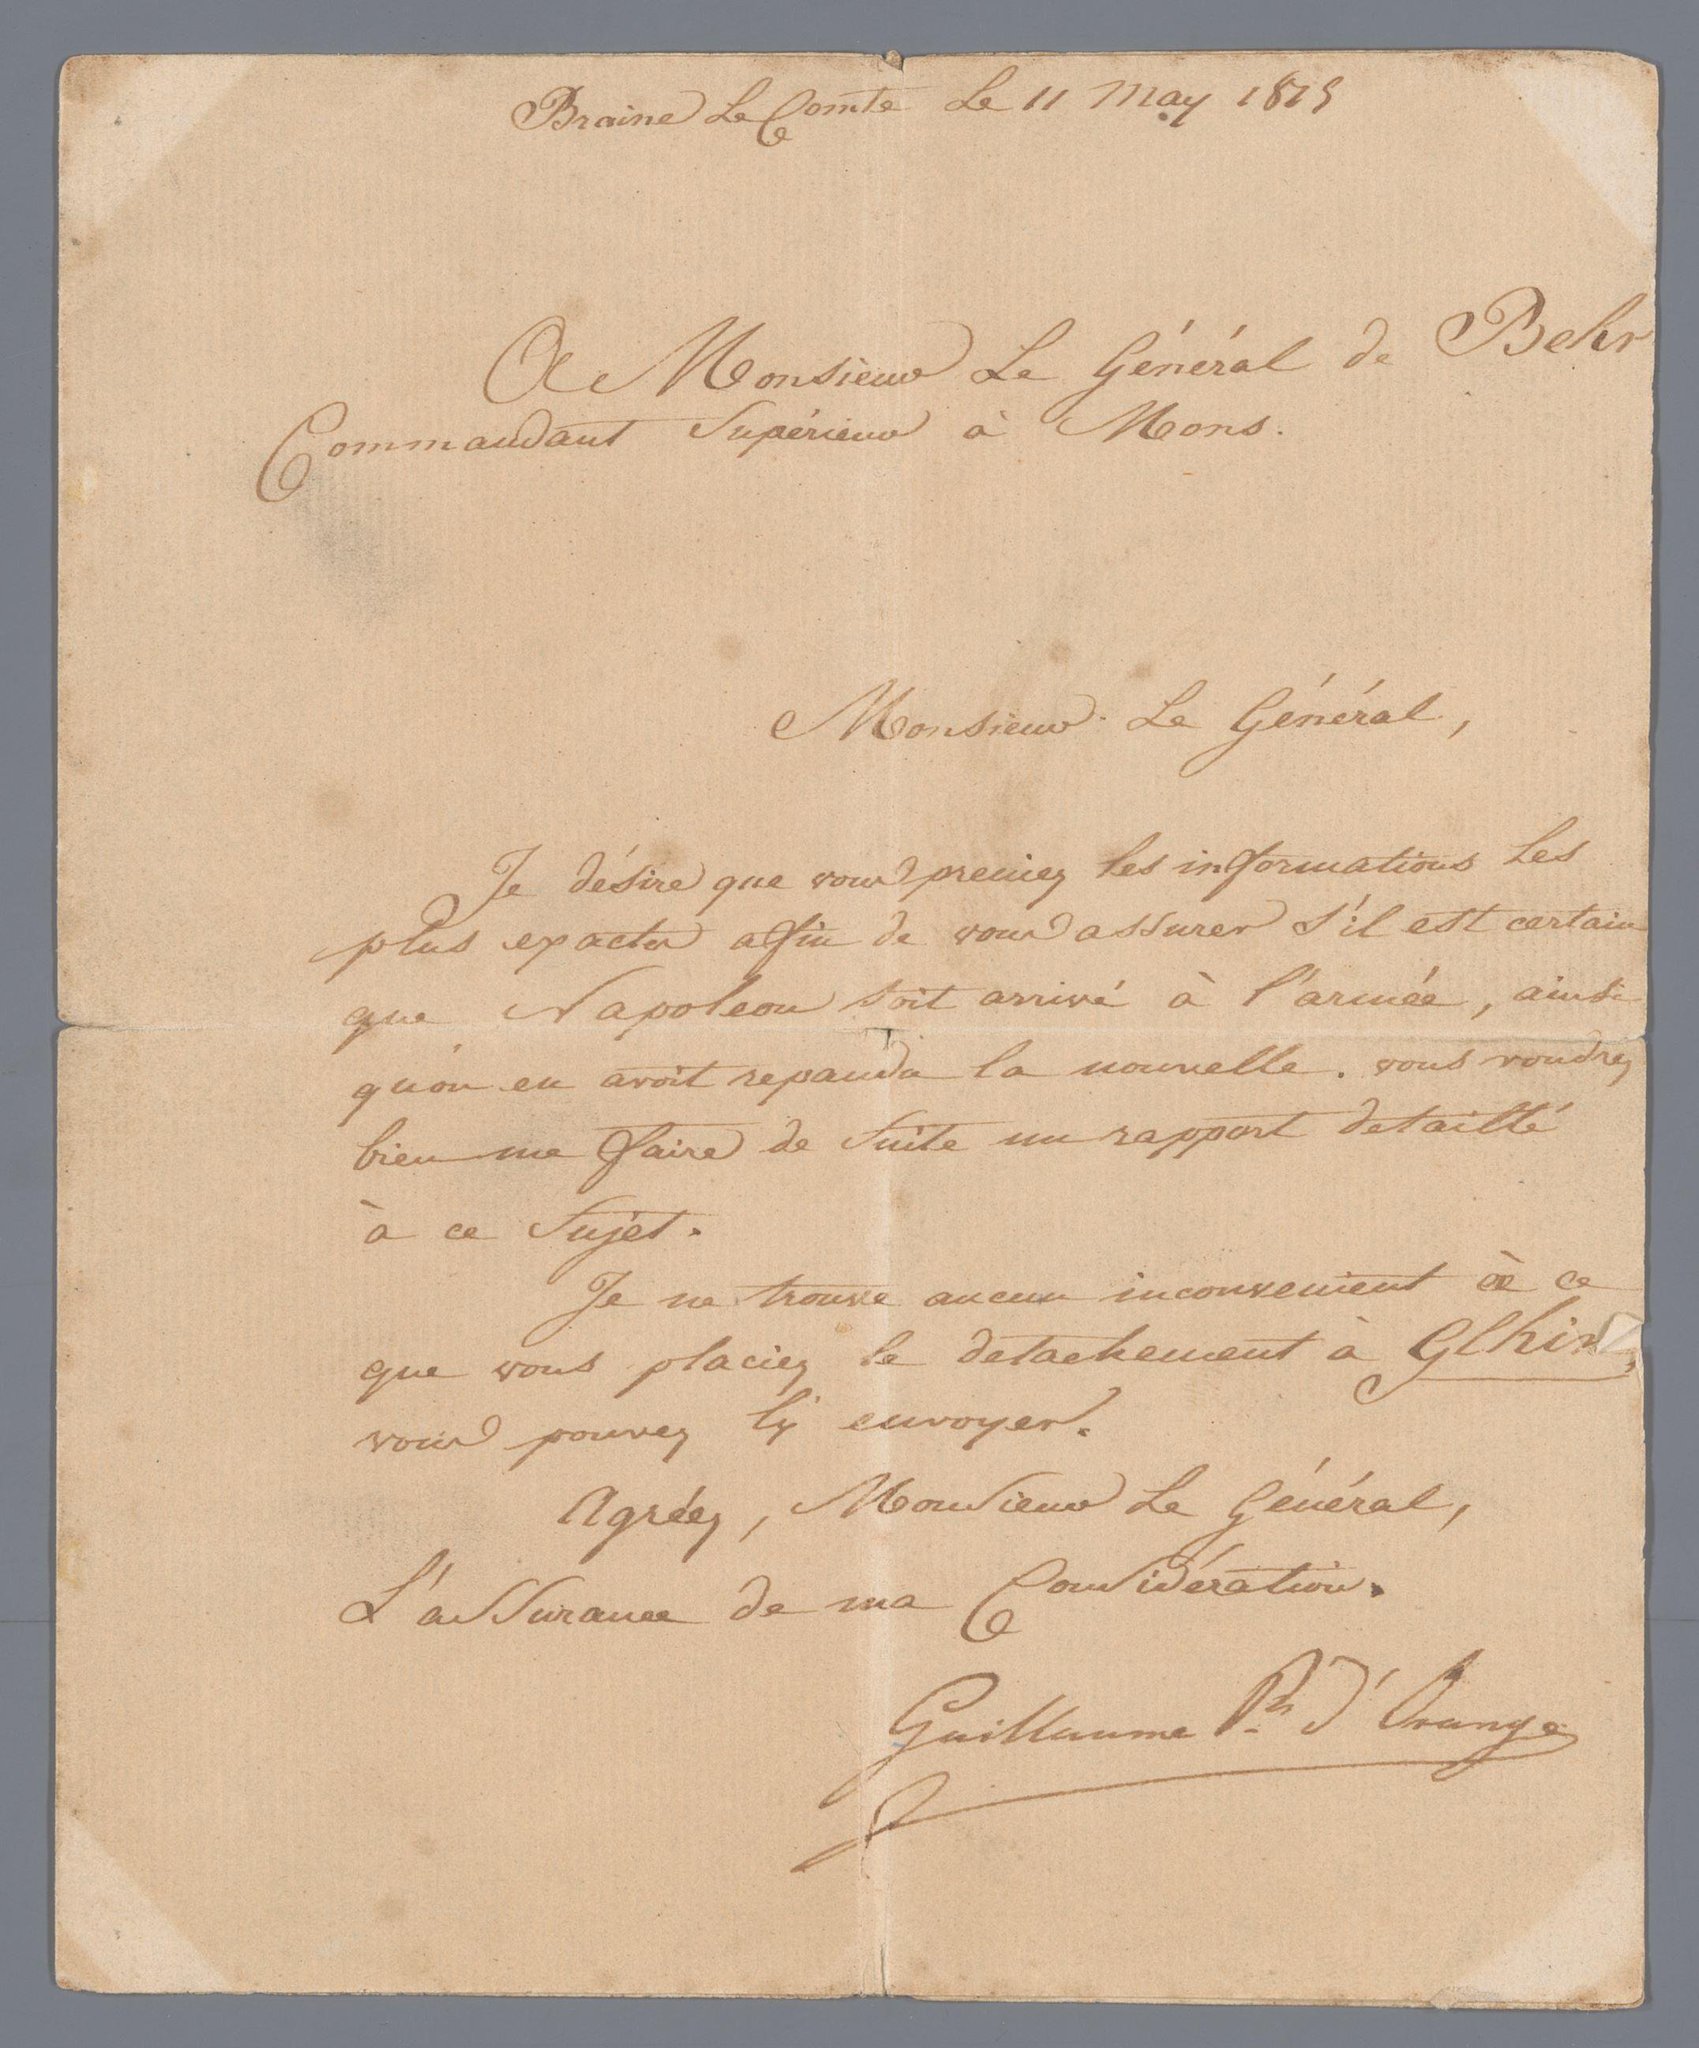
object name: letter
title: Brief van de prins van Oranje over komst Napoleon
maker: william ii of the netherlands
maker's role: koning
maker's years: 1792-1849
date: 1815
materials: paper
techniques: pen, writing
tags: the hague, william ii of the netherlands, napoleon i (emperor of the french), waterloo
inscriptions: date